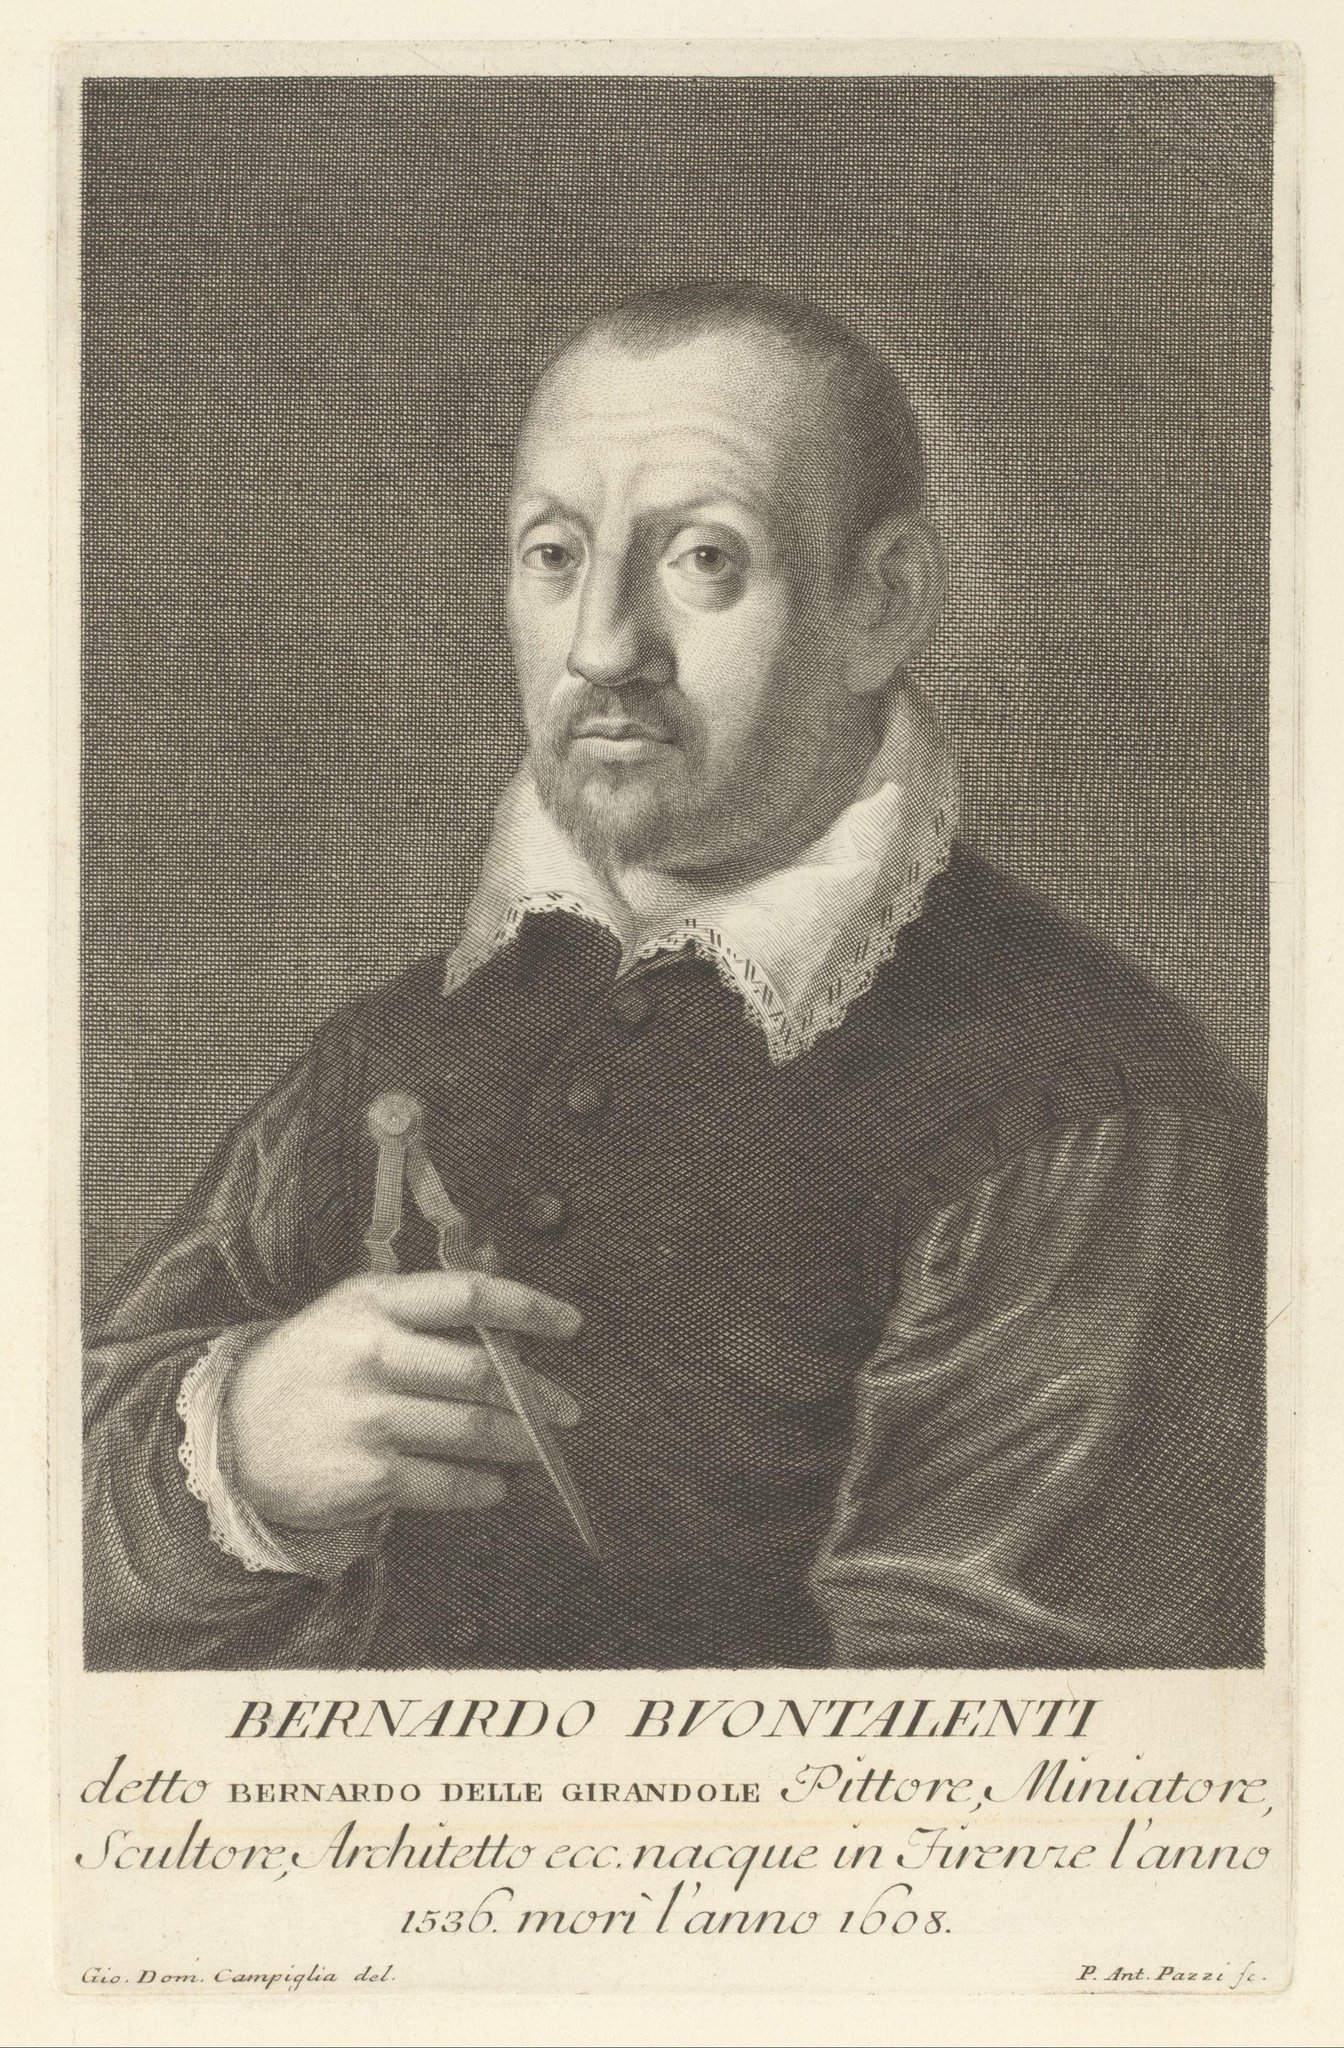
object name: print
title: Portret van Bernardo Buontalenti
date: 1752-1766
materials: paper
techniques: engraving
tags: painter, designer, bernardo buontalenti, historical persons, portrait, self-portrait of painter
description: Prent is onderdeel van een serie getiteld 'Museum Florentinum', bestaande uit vier subsecties: 'Gemmae antiquae ex Thesauro Mediceo et privatorum dactyliothecis florentiae...' (1730-1731), 'Statuae antiquae dorum et virorum illustrium' (1734), 'Antiqua numismata aurea et argentea' (1740-1741) en 'Serie di ritratti degli eccellenti pittori' (1752-1766). Het vierde deel bestaat uit 320 kunstenaarsportretten en is uitgegeven in boekvorm (vier delen). Prent uit: Moücke, Francesco. Serie di ritratti degli eccellenti pittori : dipinti di propria mano che esistono nell'Imperial galleria di Firenze. 4 dln. Florence: Francesco Moücke, 1752, dl. 1, p. 175. De samensteller heeft deze prent in het album geplakt als illustratie bij: Pilkington, Matthew en Johann Heinrich Füssli. A dictionary of painters, from the revival of the art to the present period. 4 dln. Londen: John Crowder, 1805, dl. 1, p. 94.